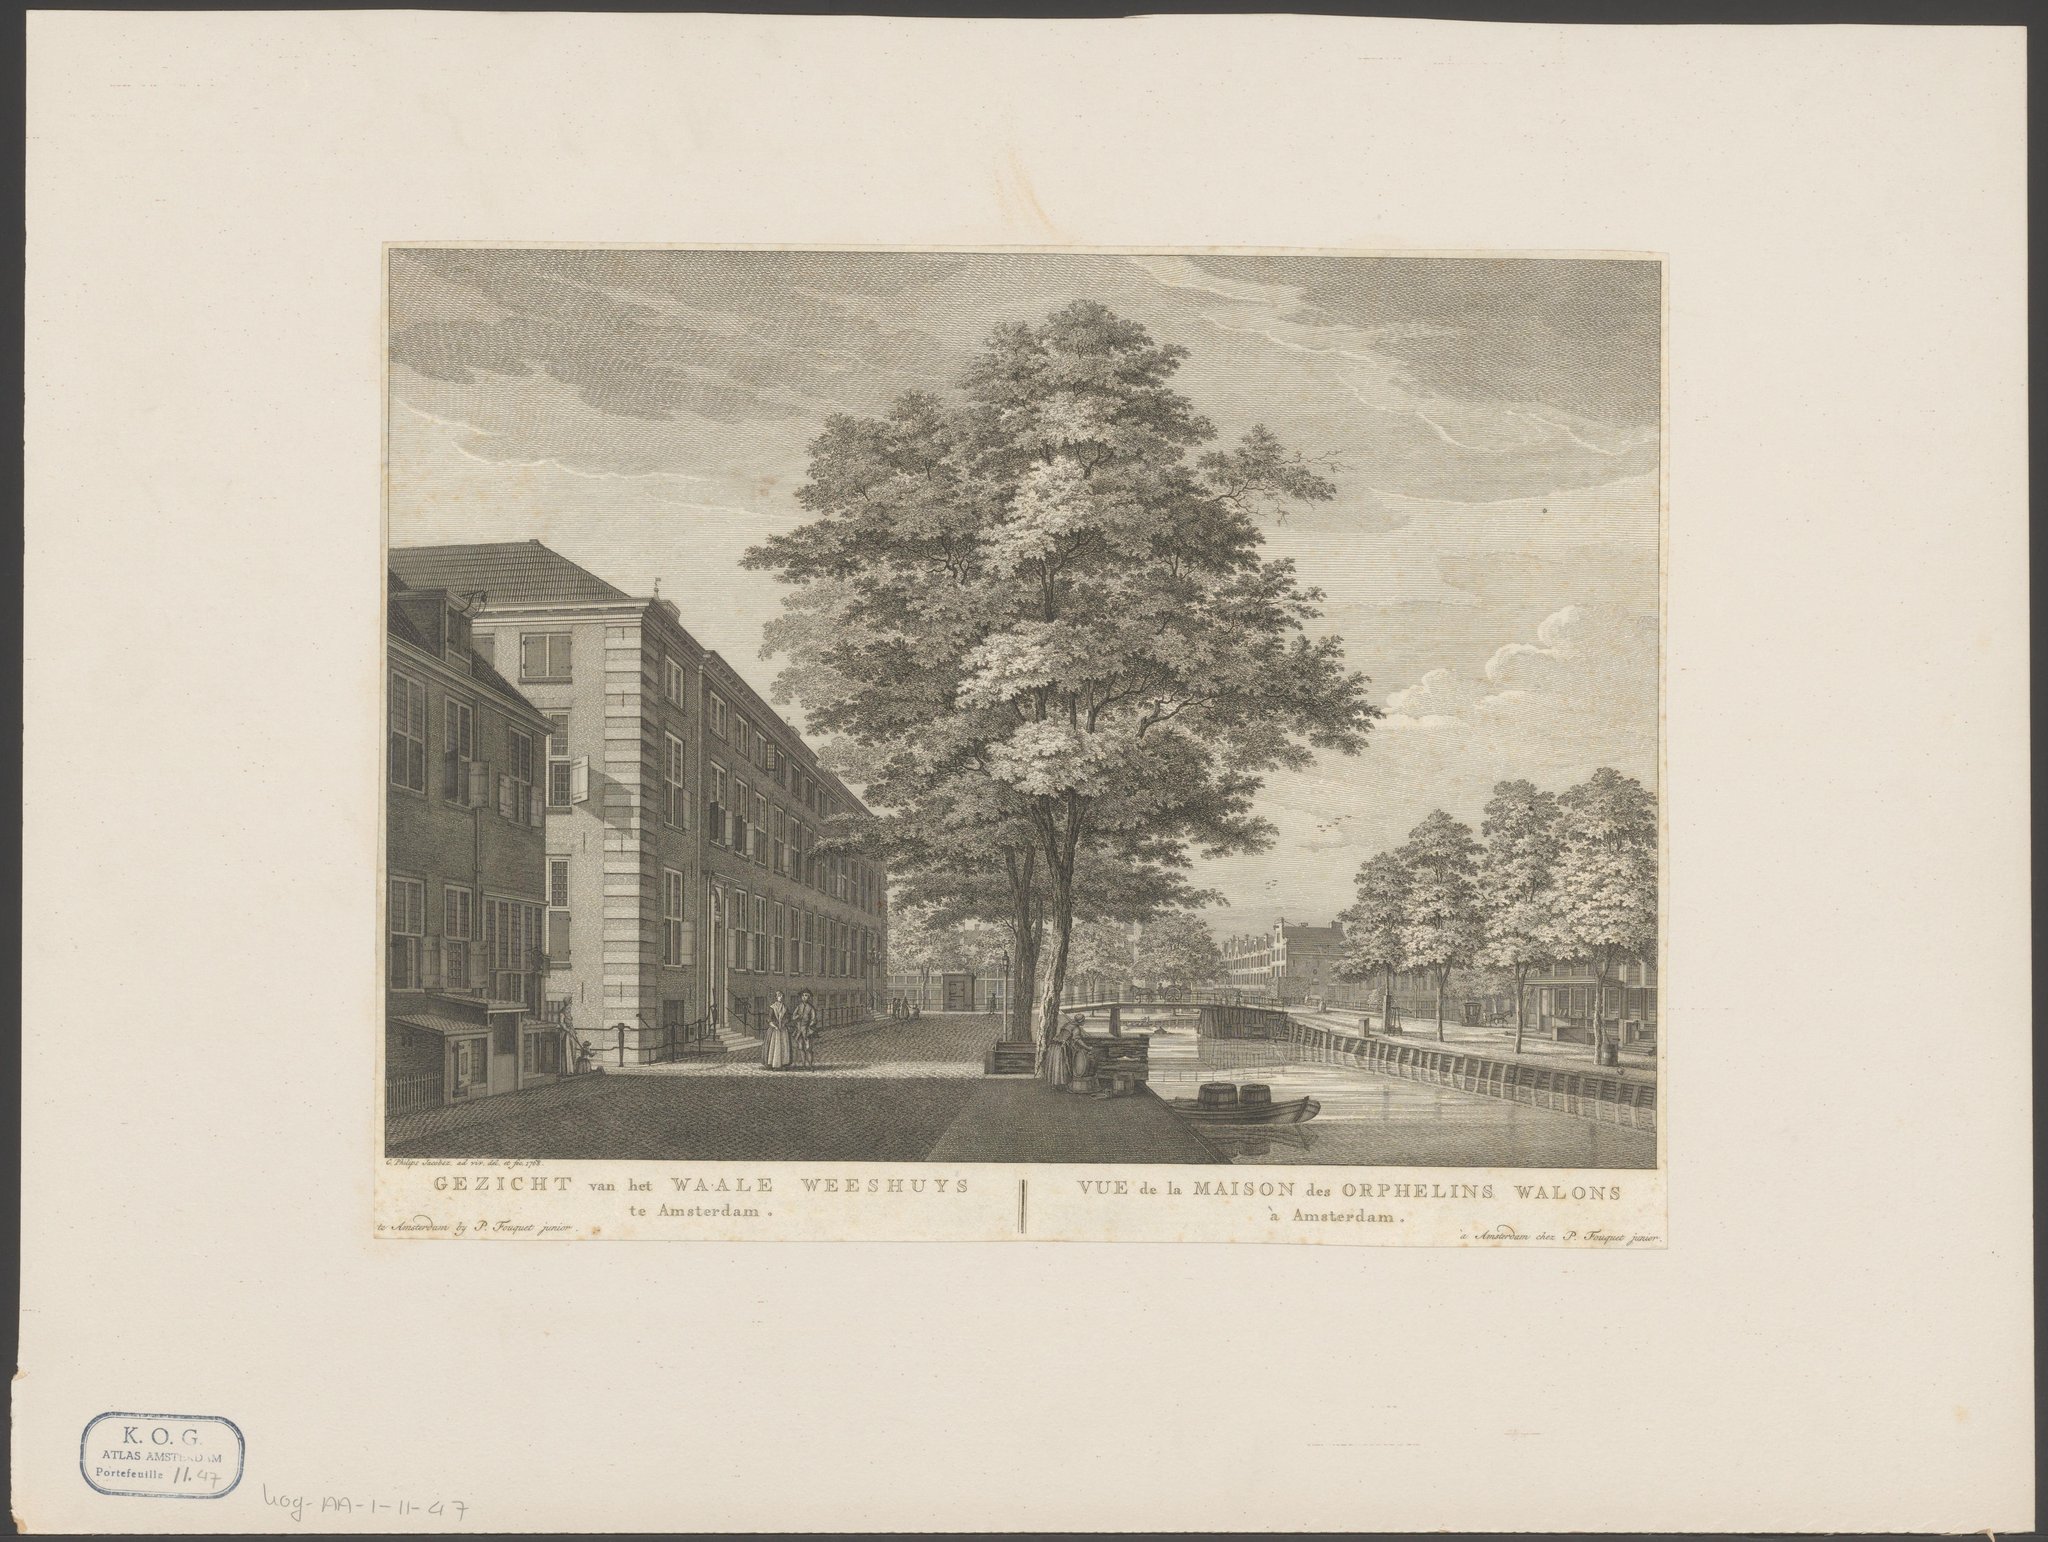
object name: print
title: Gezicht op het Walenweeshuis aan de Vijzelgracht te Amsterdam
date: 1768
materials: paper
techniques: engraving, etching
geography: amsterdam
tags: city-view in general; 'veduta', canal, orphanage, bridge in city across river, canal, etc., street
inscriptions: collector's mark: ‘11.47’ Lugt 1641b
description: Deze prent is ook gebruikt in de zogenaamde Atlas van Fouquet.* Pierre Fouquet gaf vanaf 1760 stadsgezichten van Amsterdam - naar tekeningen van verschillende kunstenaars, gemaakt door verschillende prentmakers - uit. Deze prenten werden aanvankelijk los of in series verkocht. Zoals toen gebruikelijk kon de koper de prenten zelf laten inbinden. Hiertoe gaf Fouquet tussen 1778 en 1783 een titelblad, plattegrond en inhoudsopgave van de tot dusver 100 uitgegeven prenten uit (1). Gezien de inhoud afhankelijk was van wat de koper had verzameld verschilt de inhoud van de verschillende bewaarde Fouquetatlassen onder deze titel sterk. Ook zijn er exemplaren bekend waar tevens andere prenten aan zijn toegevoegd. Omdat er behoefte bleek aan uitleg bij de platen werd in 1783 een nieuwe versie van de atlas uitgegeven, aangevuld met tekst en twee prenten. De aangegeven volgorde veranderde maar de platen van de al eerder uitgegeven prenten bleven ongewijzigd. Deze uitgave werd in opdracht van Fouquet gedrukt bij Daniël Jean Changuion en Petrus den Hengst (2). Een tiental platen werd bijgewerkt en verscheen, met nieuw impressum, in het vervolg van Wagenaars geschiedenis van Amsterdam, uitgeven door Petrus Conradi en Folkert van der Plaats (3). Een aantal jaar na het overlijden van Fouquet kwam Evert Maaskamp met een nieuwe uitgave van de atlas, met verbeterde tekst en toevoeging van twee prenten. Op alle platen verwijderde hij het oude en liet hij zijn eigen impressum zetten (4). * Onder de Atlas van Fouquet of Fouquetatlas verstaan we de hieronder vermelde publicaties (1), (2) en (4). (1). Afbeeldingen van de wyd-vermaarde koopstad Amsterdam benevens des zelvs voornaamste gebouwen en gezigten alle naar het leeven getekend / Receuil des edifices les plus considerables et des plus belles vues, de la fameuse ville d'Amsterdam, dessinées d'après nature. Amsterdam: Pierre Fouquet, 1778-1783. (2). Nieuwe atlas, van de voornaamste gebouwen en gezigten der stad Amsterdam, met derzelver beknopte beschryvingen. 2 delen. Amsterdam: Daniël Jean Changuion en Petrus den Hengst [in opdracht van Pierre Fouquet], 1783. (3). Stijl, Simon. Amsterdam, in zyne geschiedenissen, voorregten, koophandel, gebouwen, kerkenstaat, schoolen, schutterye, gilden en regeeringe, beschreeven. Om te dienen ten vervolge op het werk van Jan Wagenaar (…). 10 delen. Amsterdam en Harlingen: Petrus Conradi en Folkert van der Plaats, 1788-1801. (4). Nieuwe atlas, van de voornaamste gebouwen en gezigten der stad Amsterdam. Met derzelver beknopte beschryvingen. Amsterdam: Evert Maaskamp, 1805.